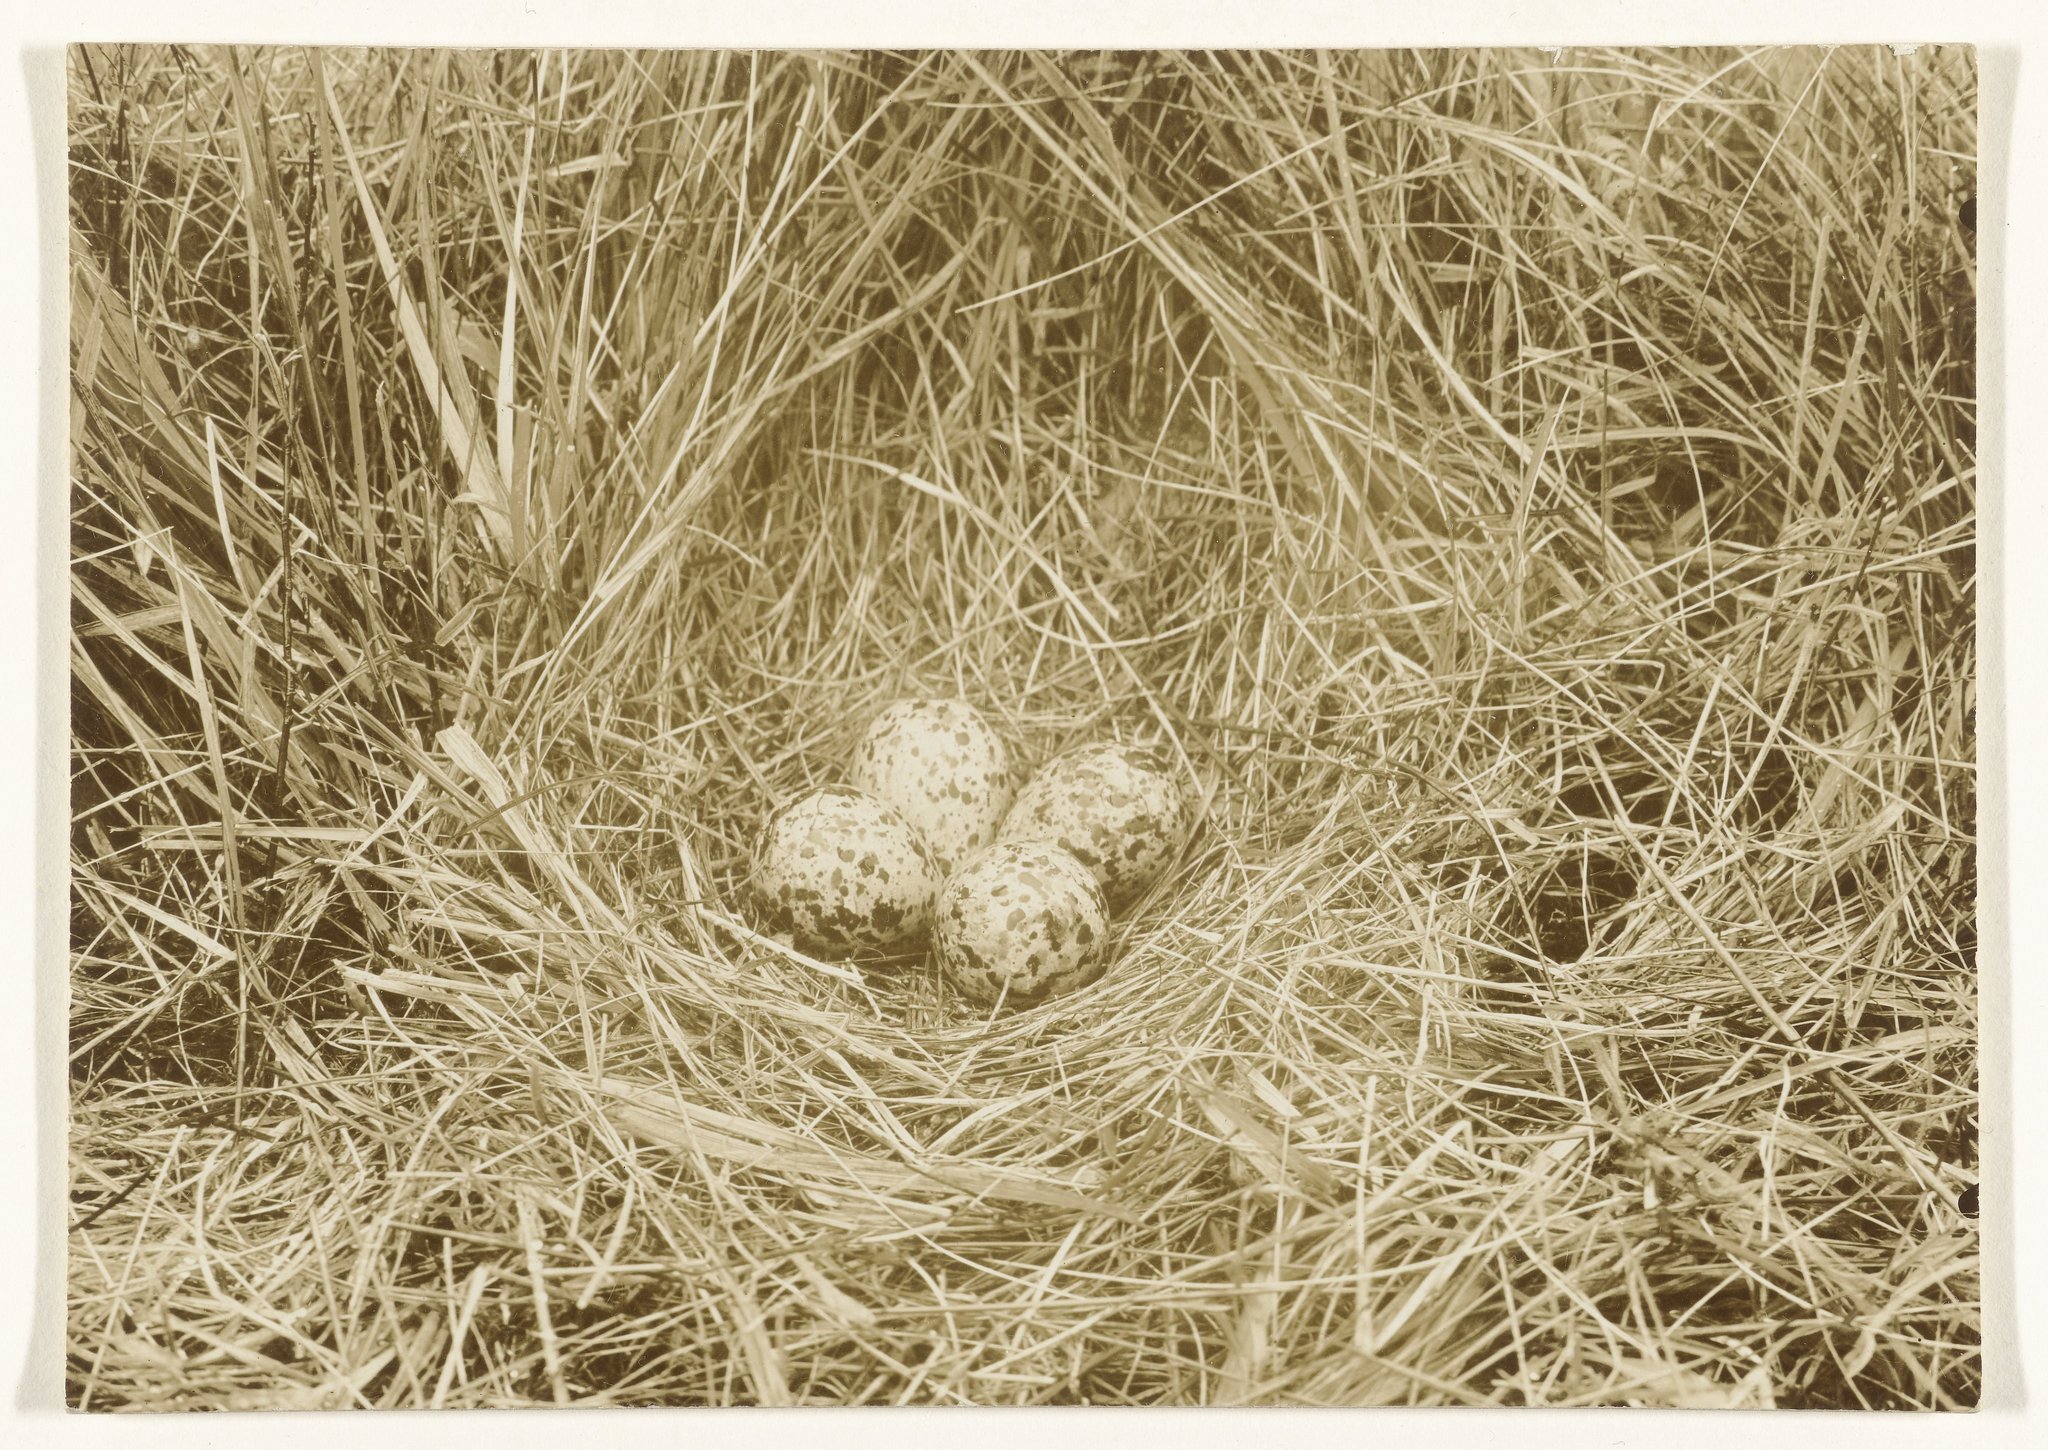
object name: photograph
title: Nest met eieren van een tureluur op Texel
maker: richard tepe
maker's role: fotograaf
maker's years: 1864-1952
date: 1900-1930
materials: photographic support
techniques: gelatin silver print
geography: netherlands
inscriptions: annotation: ‘Nest en eieren van den Tureluur / op Texel / Nest und Eier / des Rothschenkels’, signature: ‘foto / R. Tepe’